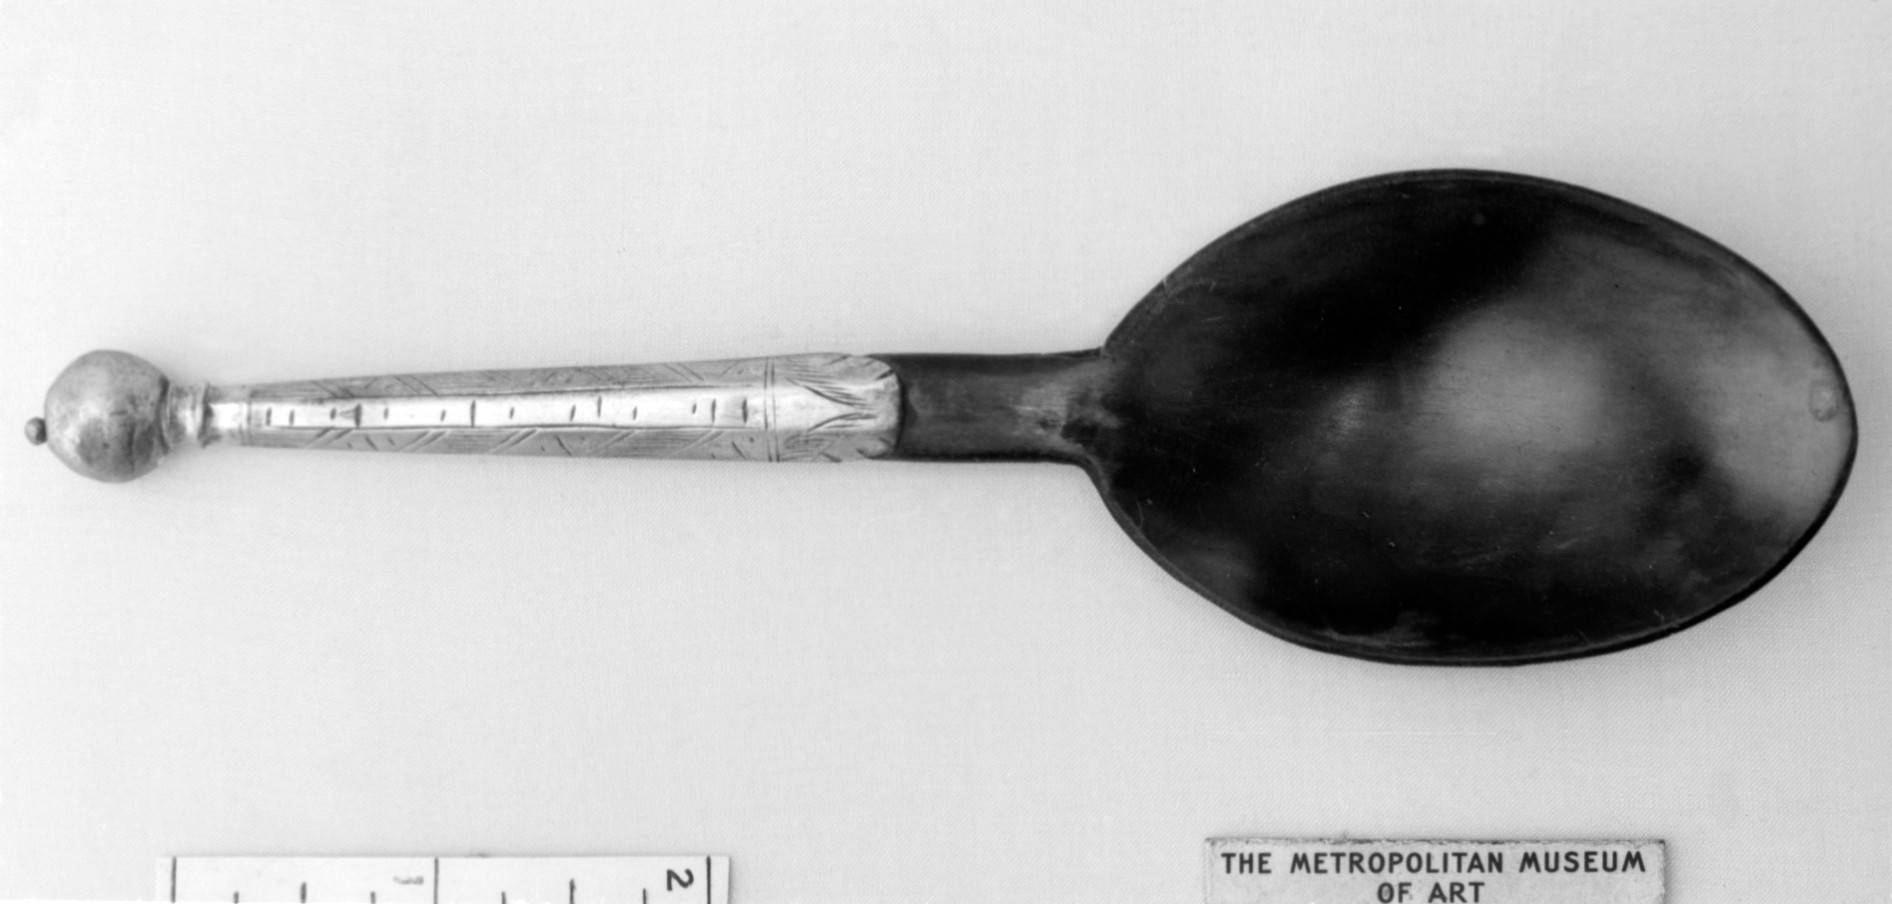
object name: spoon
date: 1701-1800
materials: horn, metal